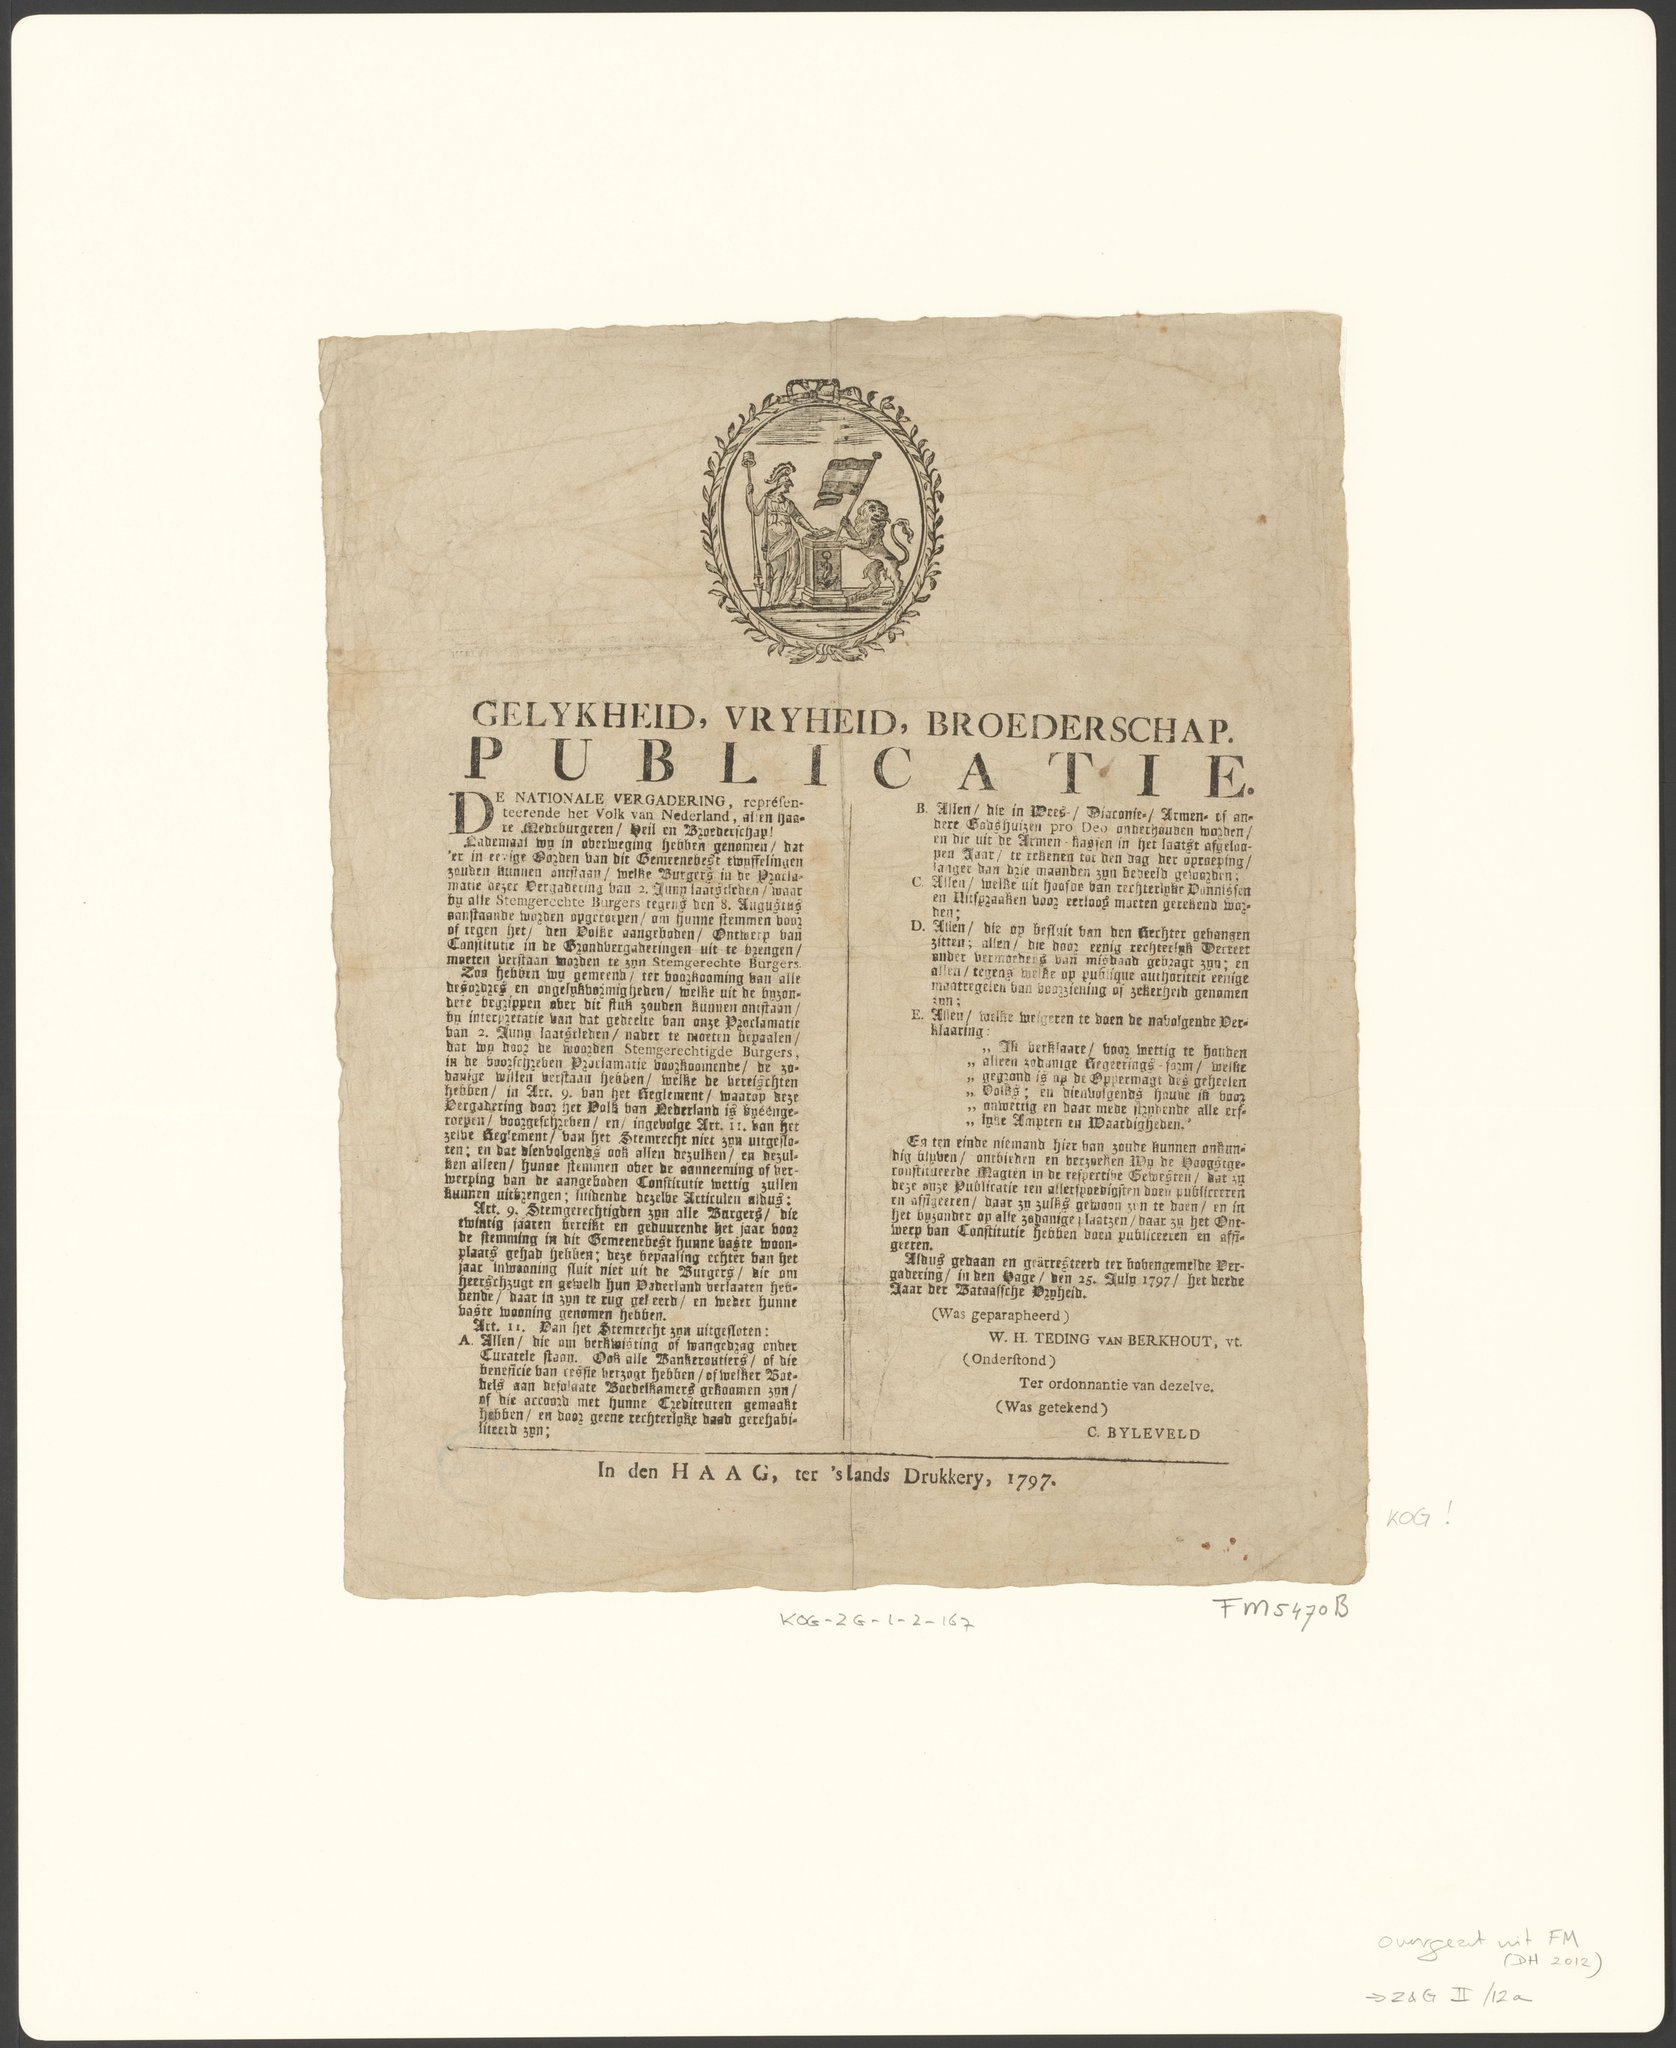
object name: publication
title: Publicatie van de Nationale Vergadering, 25 juli 1797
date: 1707-1797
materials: paper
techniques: letterpress printing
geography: the hague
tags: national government, newspaper, news-sheet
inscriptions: collector's mark: Lugt 1641, collector's mark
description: Publicatie van de Nationale Vergadering van de Bataafse Republiek, Den Haag, 25 juli 1797. Onderaan de namen van W.H. Teding van Berkhout en C. Byleveld. Gedrukte tekst in twee kolommen met bovenaan een vignet met de Vrijheid. Onderwerpsrubrieken binnen de Atlas Zeden en Gewoonten: Regeering, Publicaties.